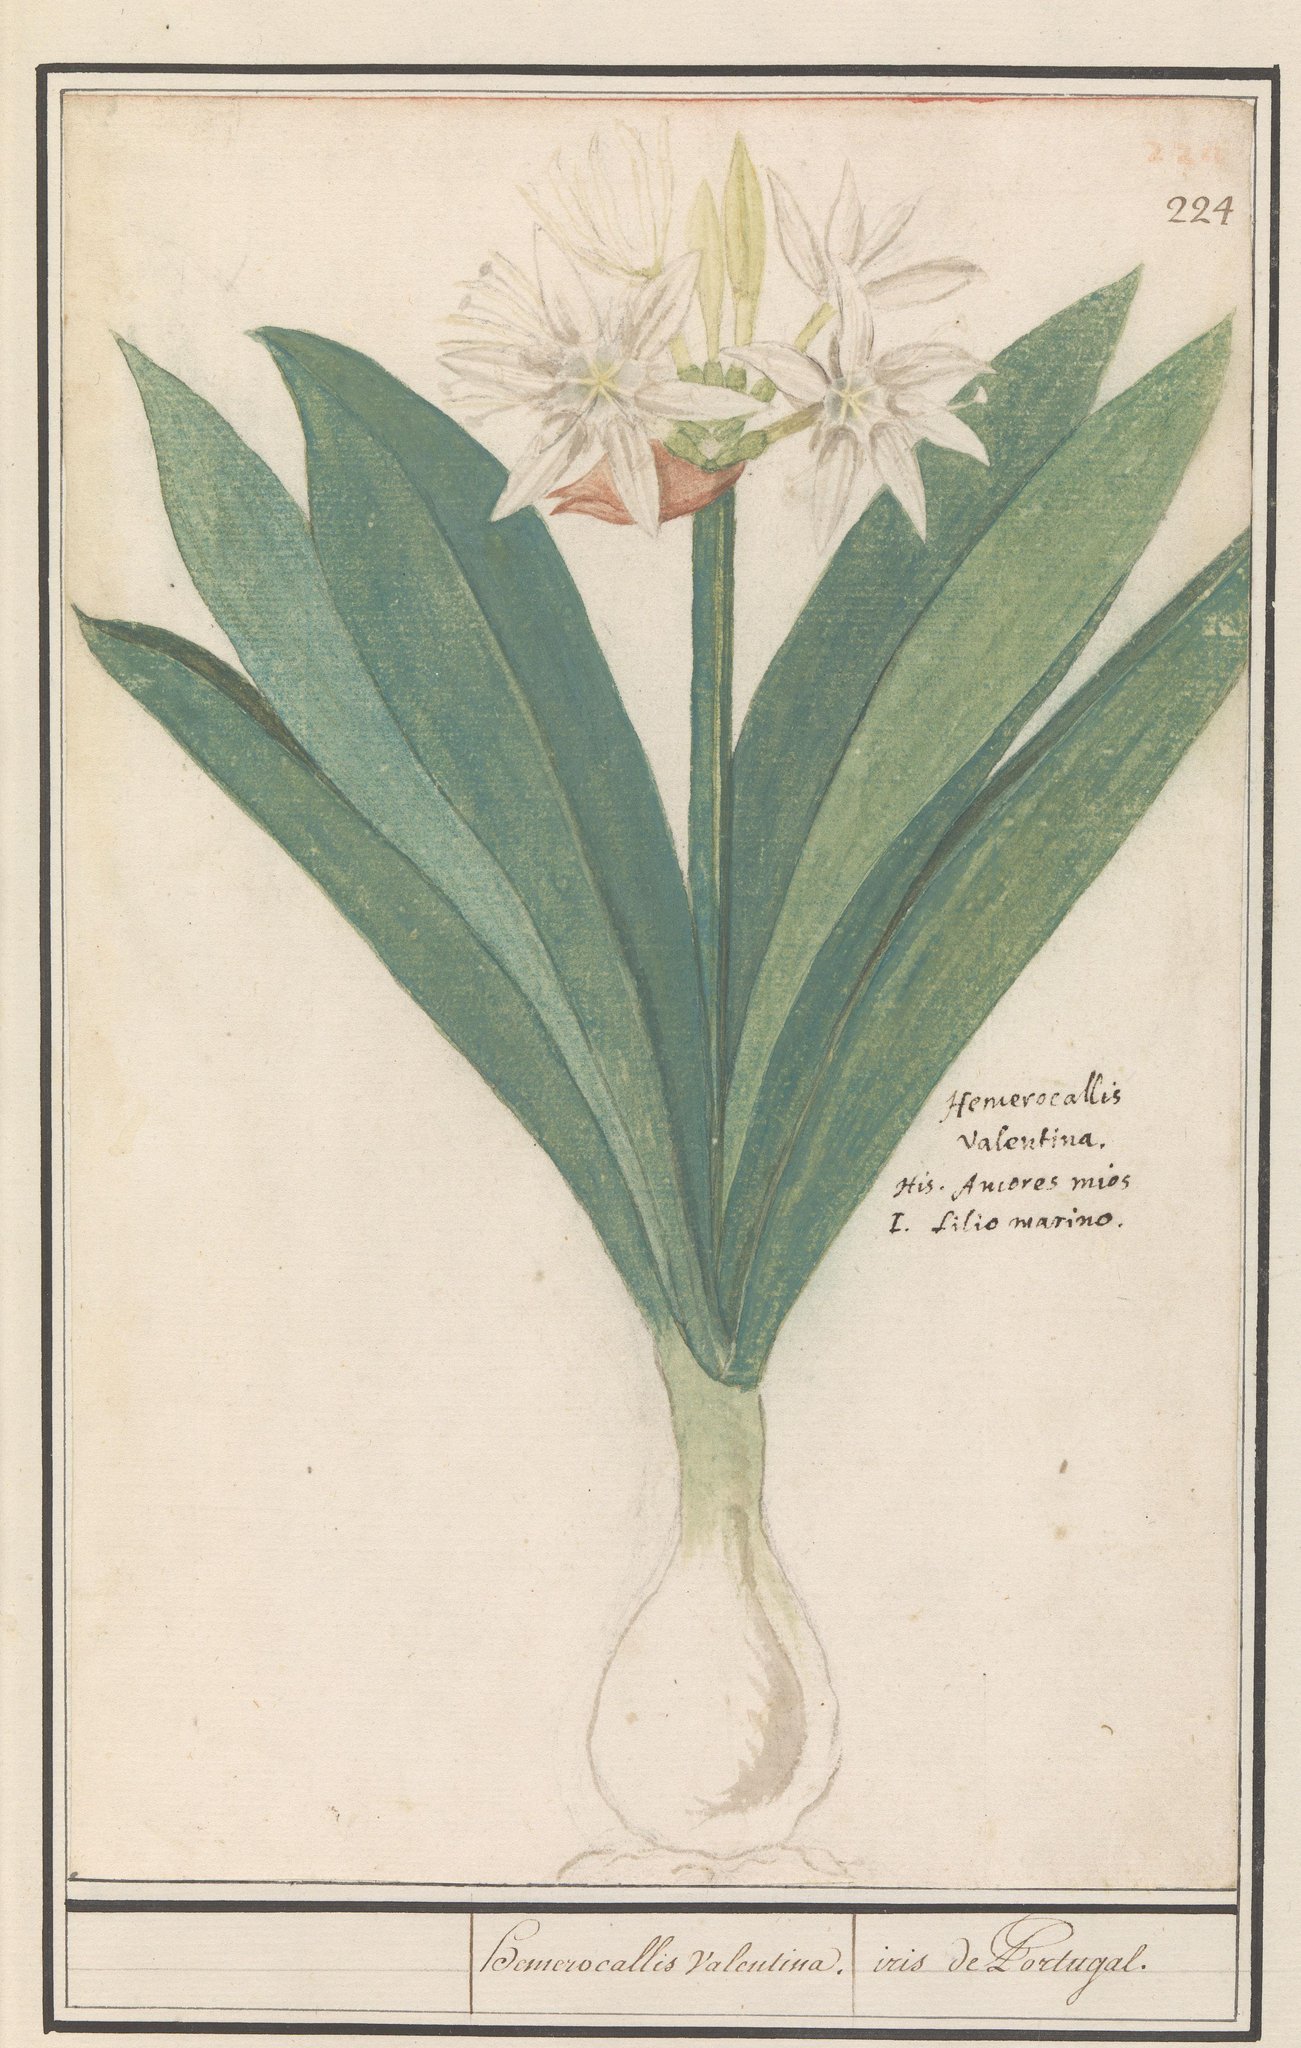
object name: drawing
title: Amaryllis (Hippeastrum)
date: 1596-1610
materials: chalk, paint, ink, paper, watercolor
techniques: brush, pen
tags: flowers: amaryllis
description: Amaryllis met witte bloemen, in het onderschruft aangeduid als een daglelie. Genummerd rechtsboven: 224. Rechts de naam in drie talen. Onderdeel van het derde album met tekeningen van bloemen en planten. Tiende van twaalf albums met tekeningen van dieren, vogels en planten bekend rond 1600, gemaakt in opdracht van keizer Rudolf II. Met toelichting in Nederlands, Latijn en Frans.